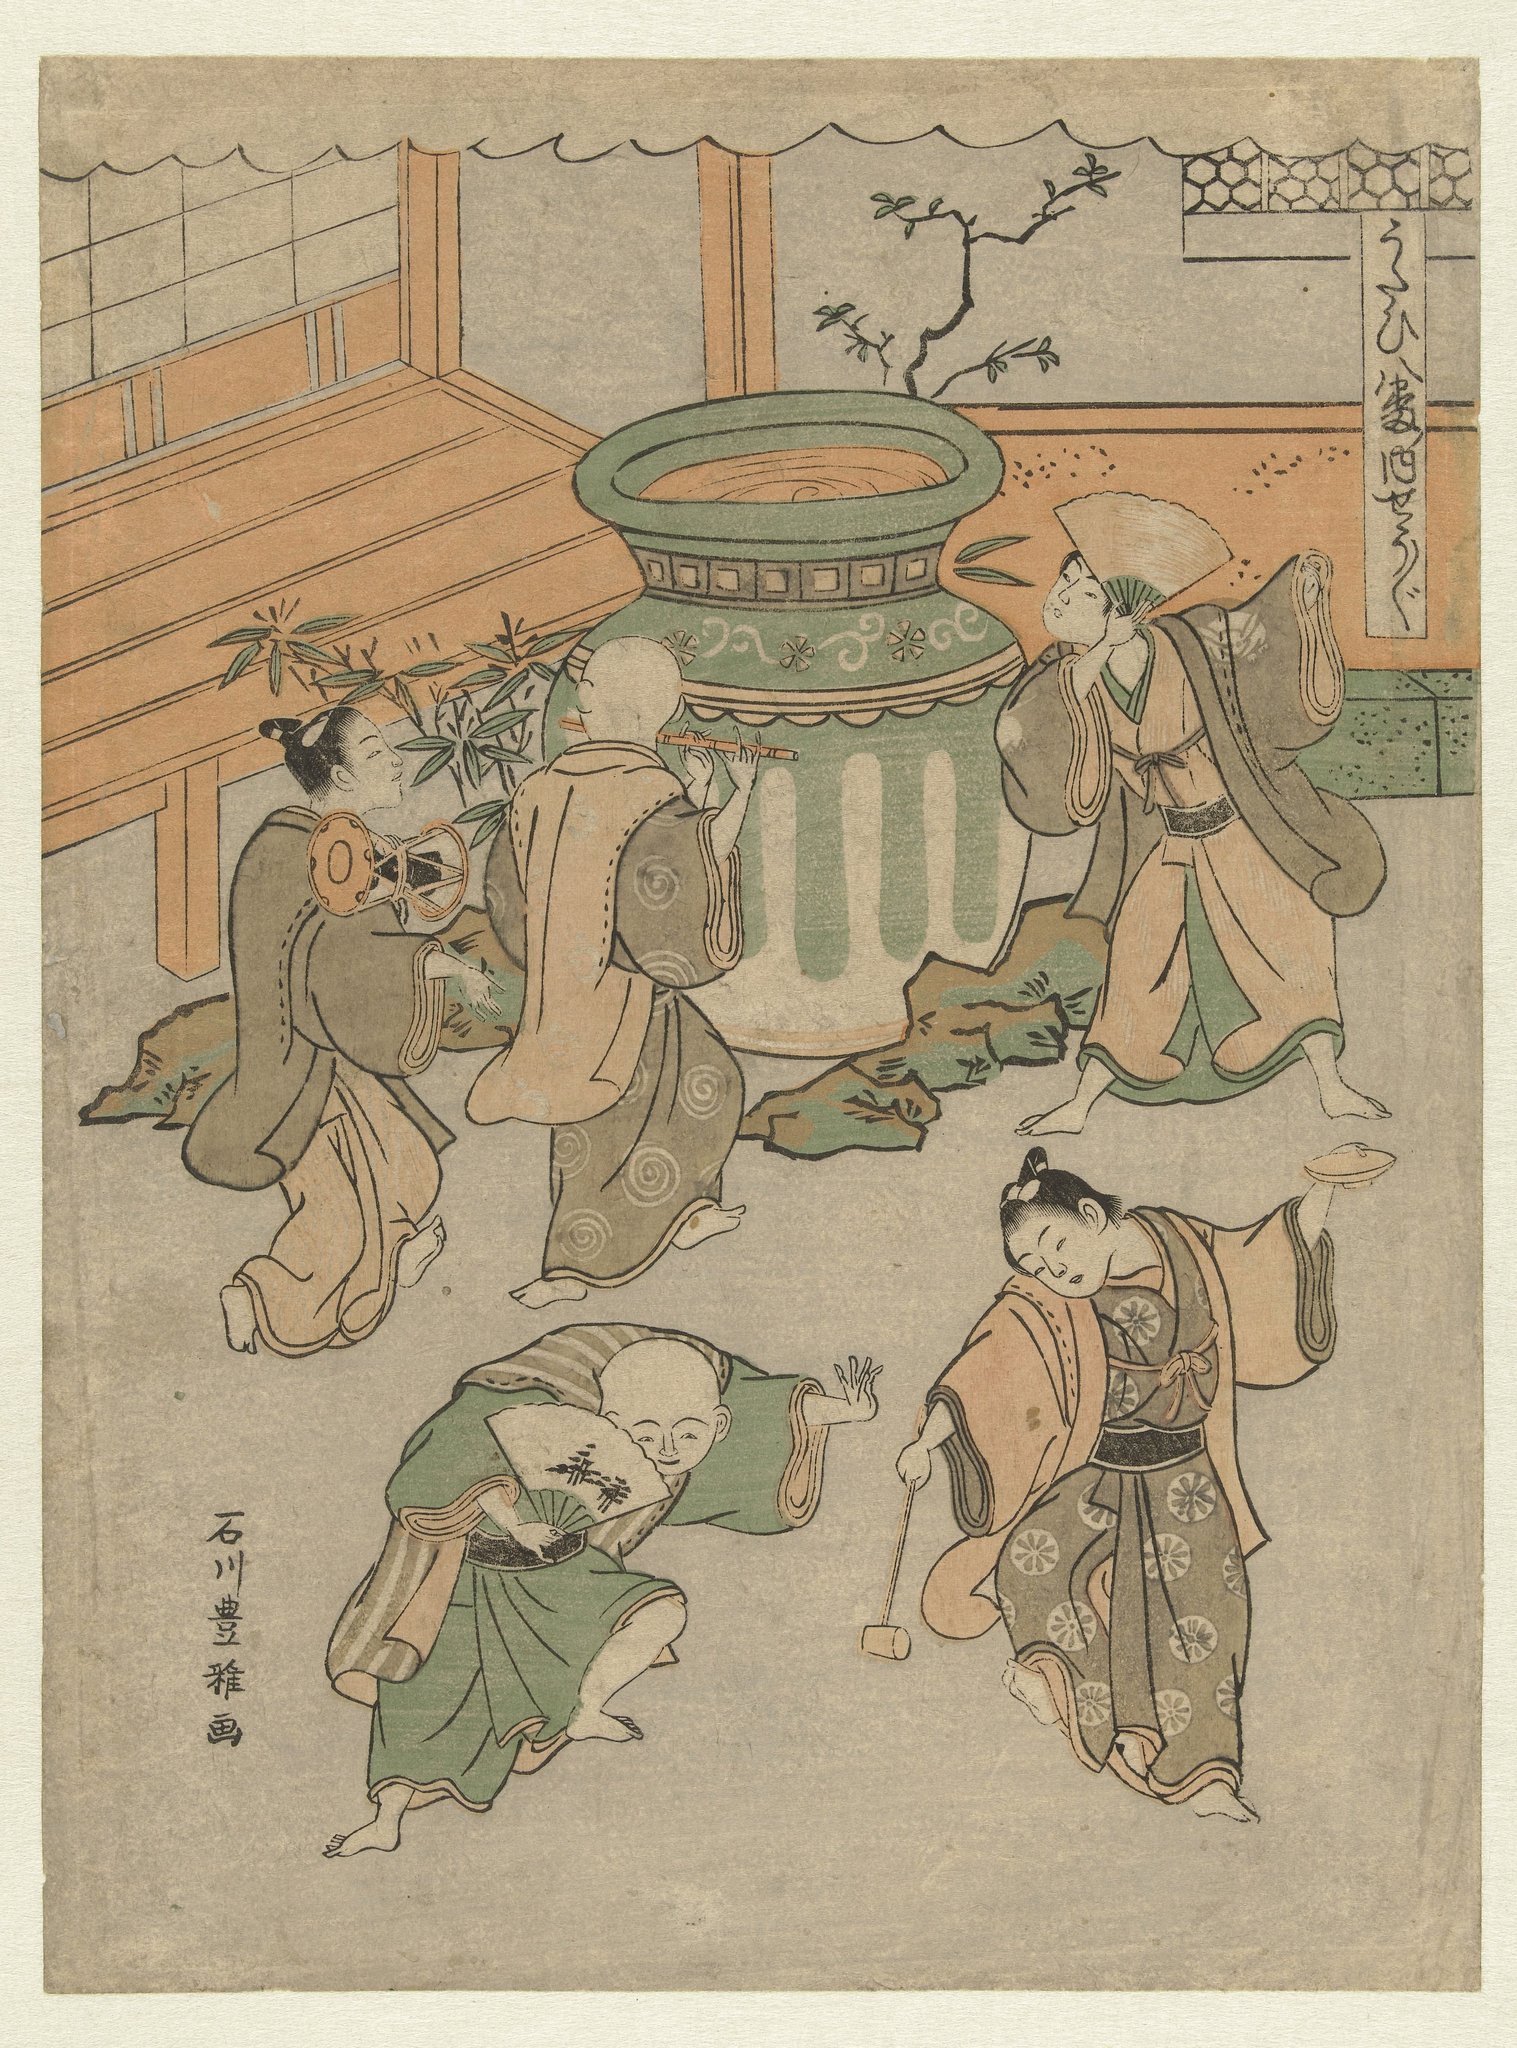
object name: print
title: Shojo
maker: ishikawa toyomasa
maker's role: print maker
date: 1770-1780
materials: paper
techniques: blind stamped, woodcut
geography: japan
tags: dancing, children playing musical instruments, container of ceramics: jar, jug, pot, vase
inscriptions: collector's mark: Lugt 2228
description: Vijf kinderen, muziek makend en dansend, in een tuin bij een reusachtig sake vat; op de achtergrond een deel van een huis met veranda.